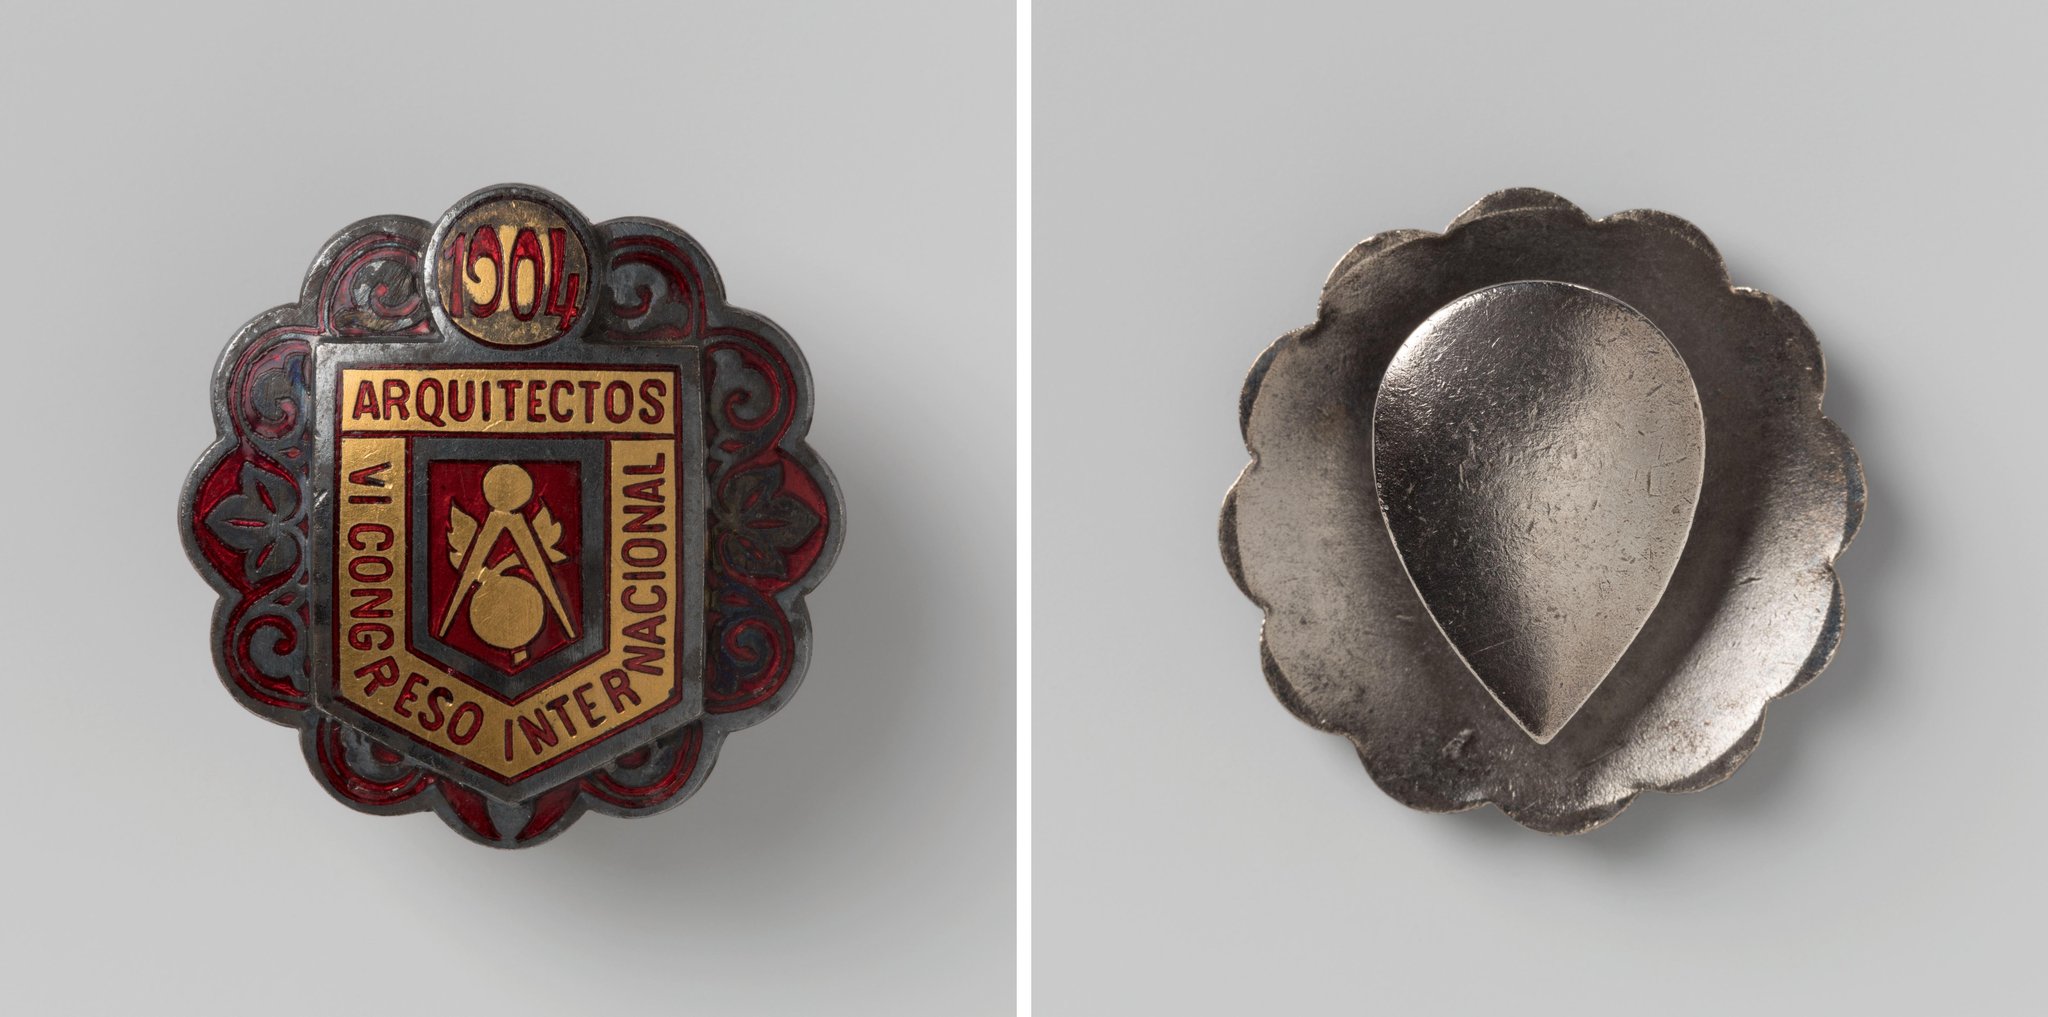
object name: insignia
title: VIe internationale congres van architecten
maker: Anonymous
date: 1904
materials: silver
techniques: striking, welding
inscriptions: inscription: ‘VI CONGRESO INTERNACIONAL ARQUITECTOS’